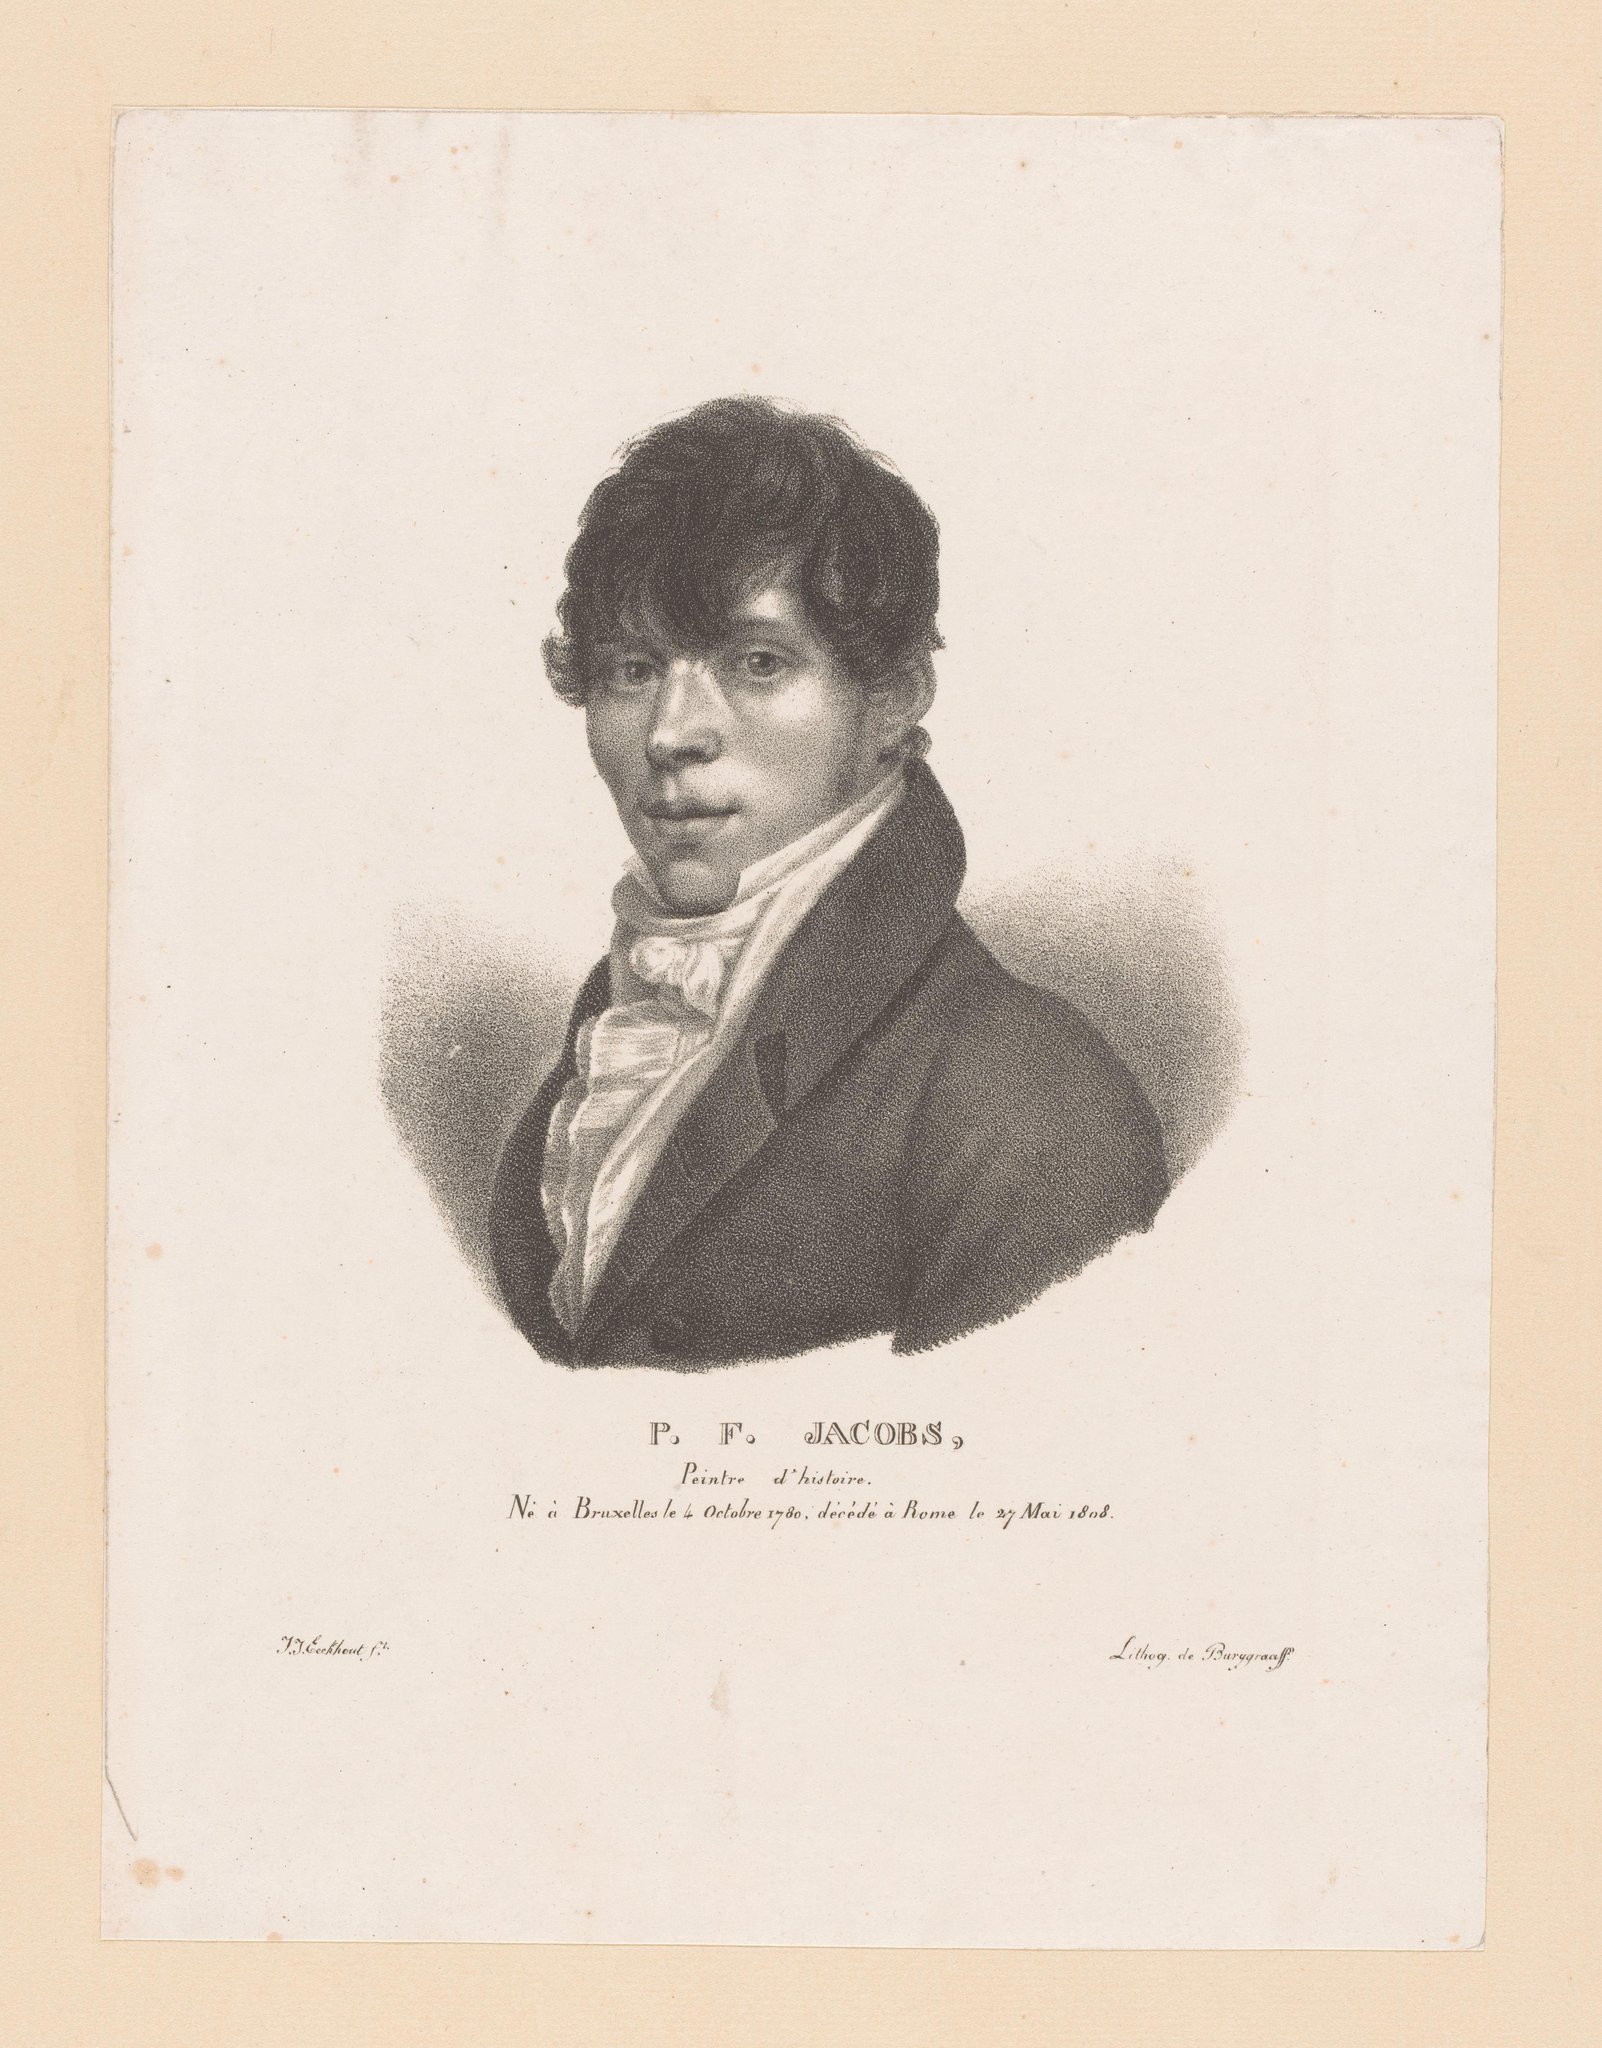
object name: print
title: Portret van Pieter Frans Jacobs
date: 1822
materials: paper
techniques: lithograph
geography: brussels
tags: brussels, rome, historical persons, portrait, self-portrait of painter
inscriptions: collector's mark: Lugt 2228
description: Prent maakt deel uit van een serie van zestig prenten.